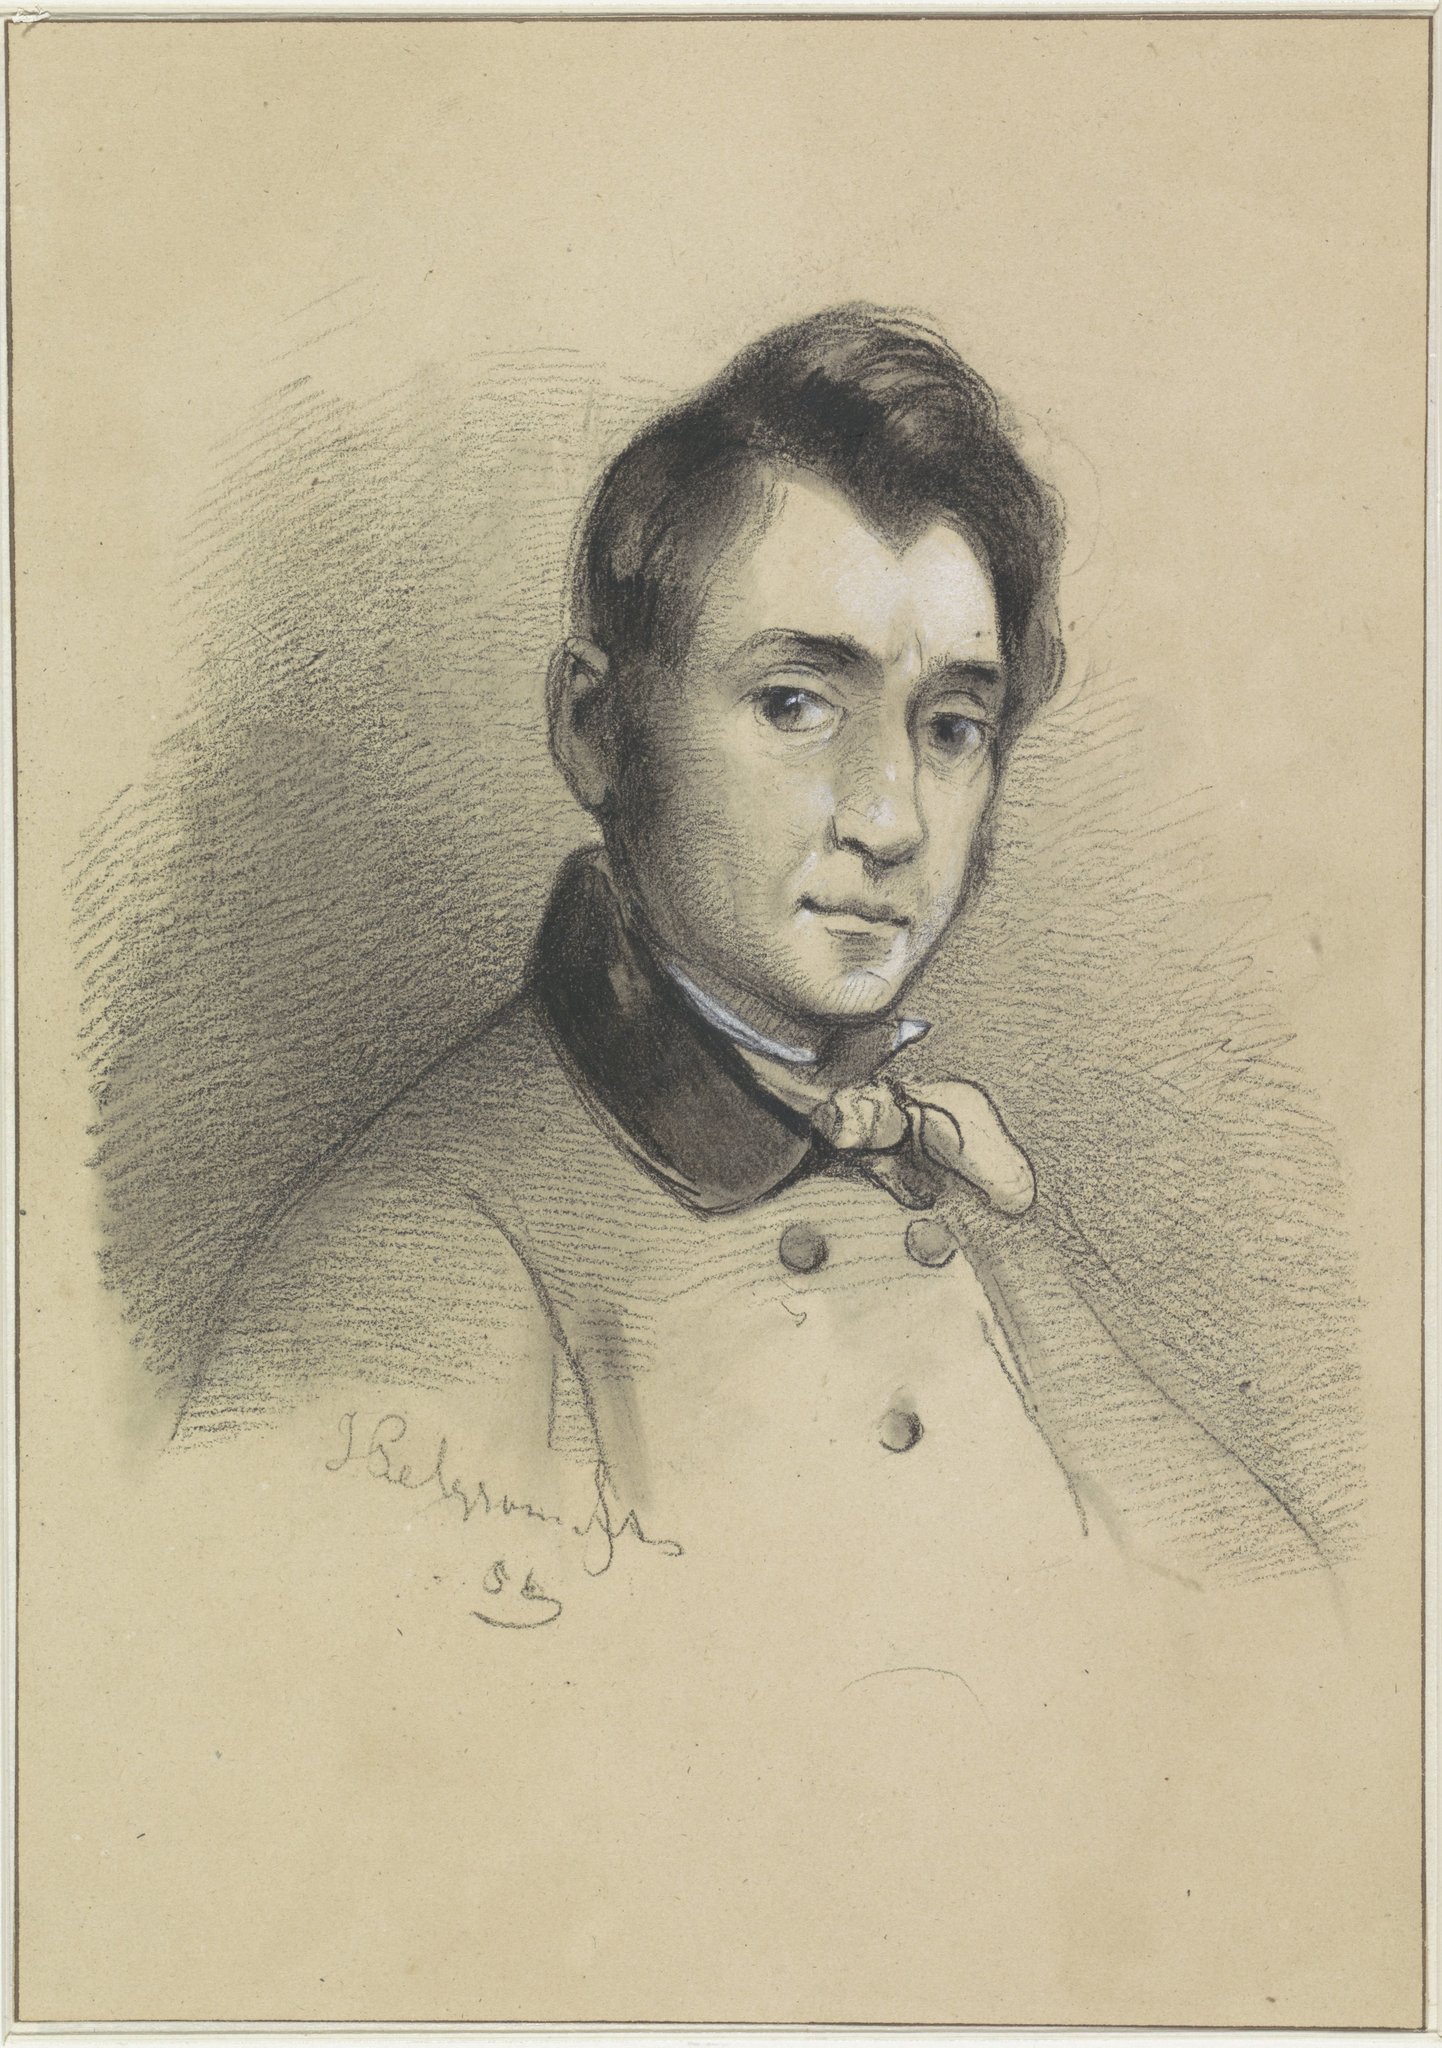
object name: drawing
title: Zelfportret van Jacobus Pelgrom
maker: jacobus pelgrom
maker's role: draughtsman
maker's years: 1811-1861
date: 1859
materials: chalk, paper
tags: amsterdam, draughtsman, jacobus pelgrom, historical persons, portrait, self-portrait of artist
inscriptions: date: ‘59’